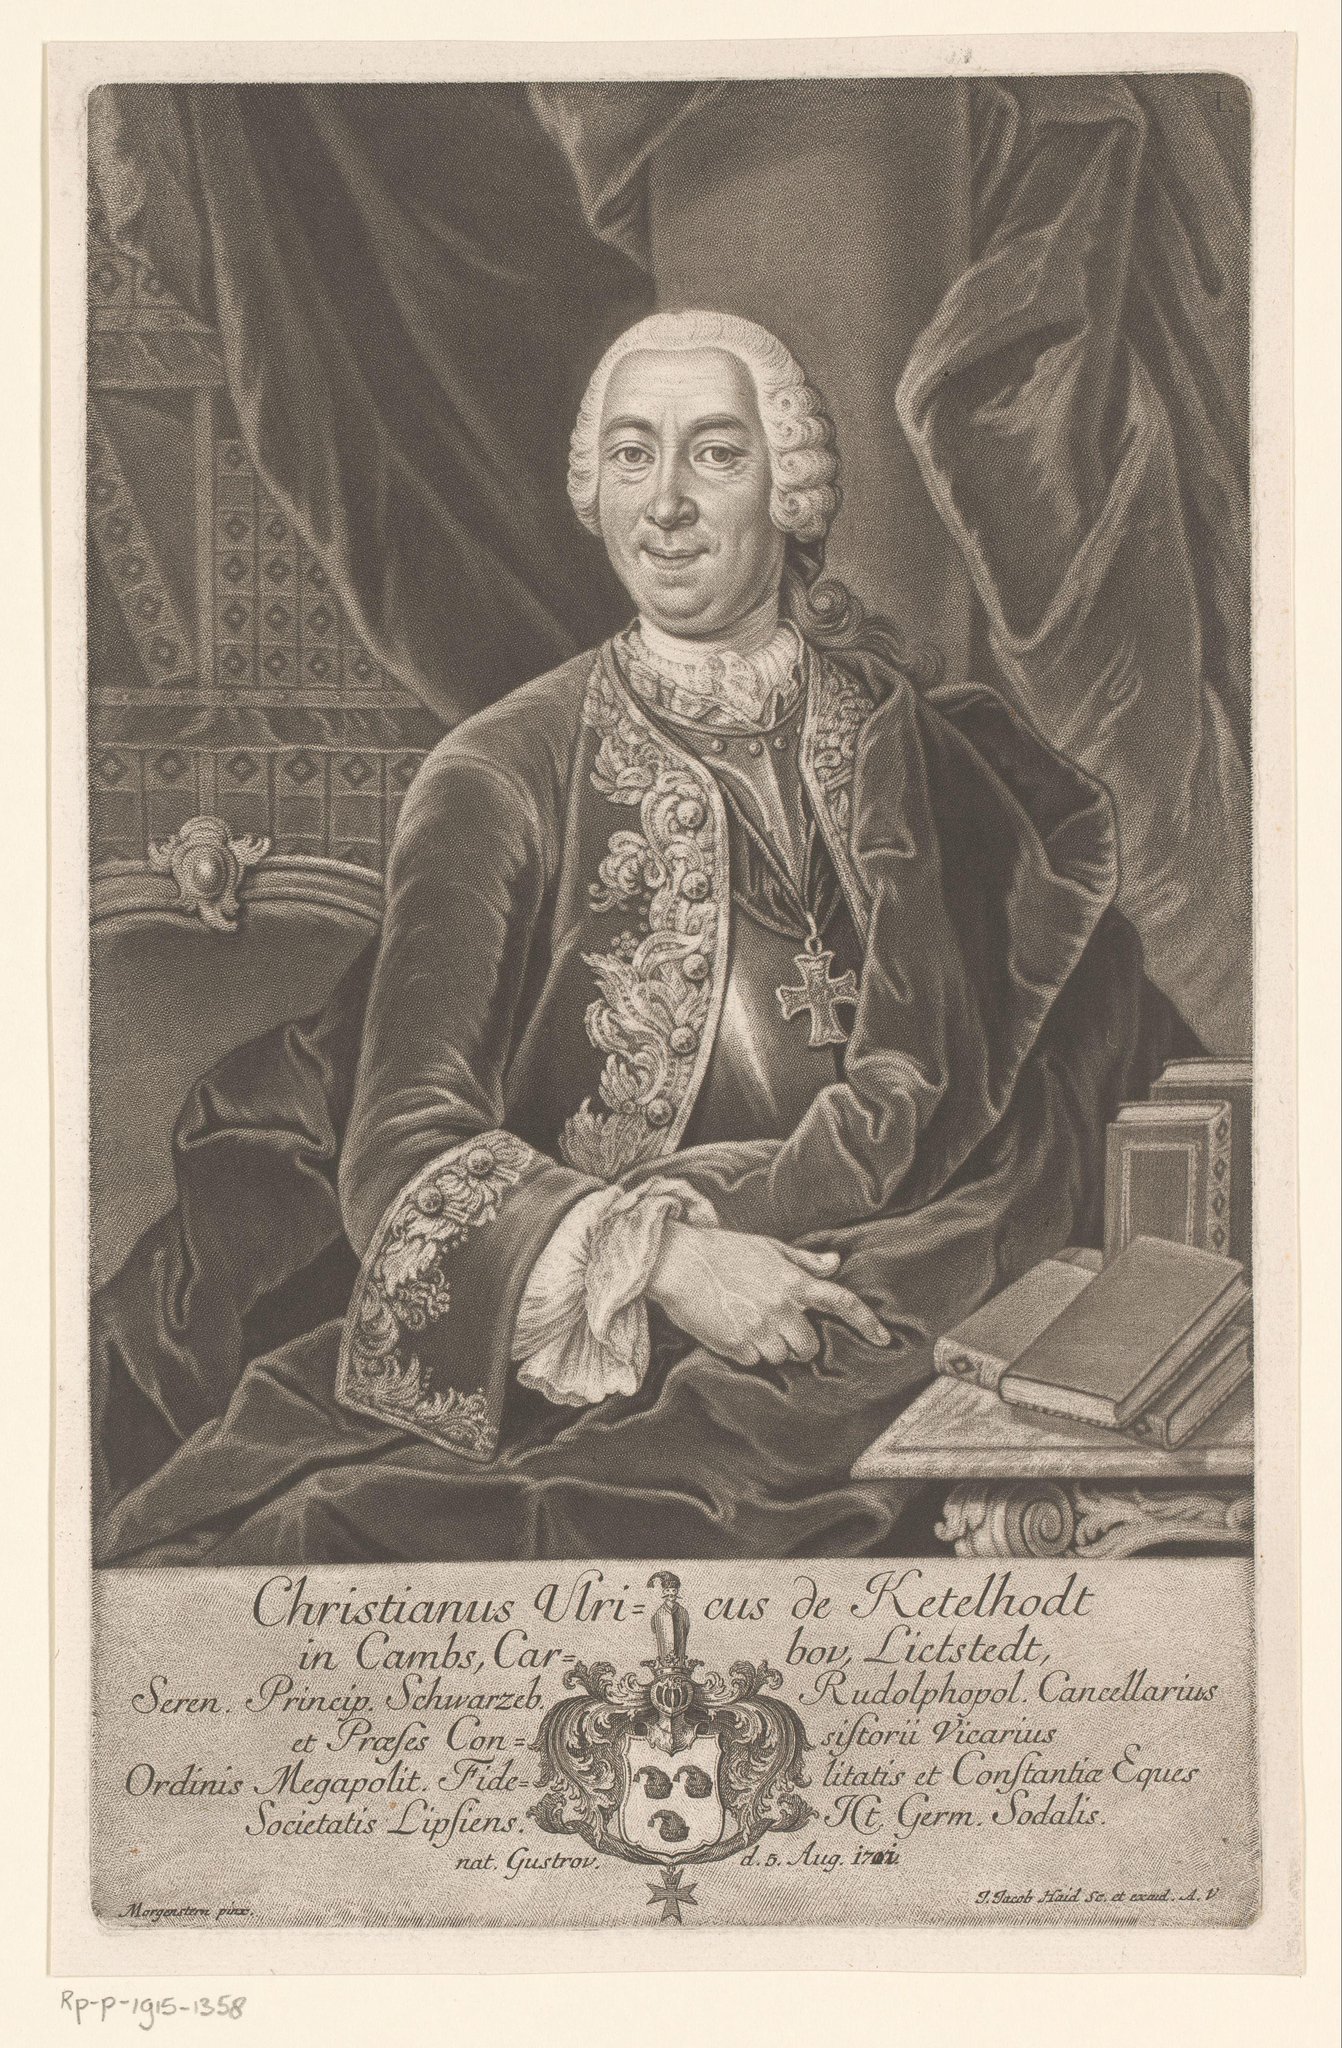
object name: print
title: Portret van Christian Ulrich von Ketelhodt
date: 1757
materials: paper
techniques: etching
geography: augsburg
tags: bookshelves, historical persons, book, armorial bearing, heraldry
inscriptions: collector's mark: Lugt 2228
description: Prent gebruikt voor: Haid, Johann Jacob. Neue Sammlung von Bildnissen gelehrter (...) noch lebender Männer. Augsburg: Johann Jacob Haid, 1757.